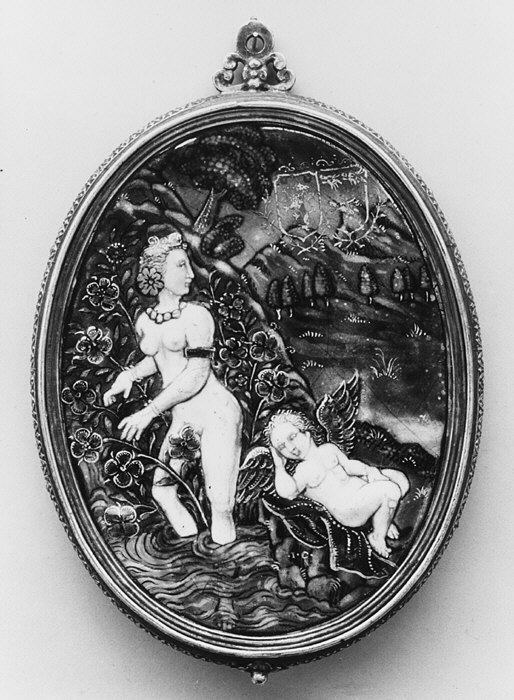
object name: mirror back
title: Venus and the Rose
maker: master i. c. (probably jean court or jean de court)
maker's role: artist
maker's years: 1550-1599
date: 1567-1600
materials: copper, enamel, gilt, glass, silver gilt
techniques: painting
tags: sleeping,cupid,venus